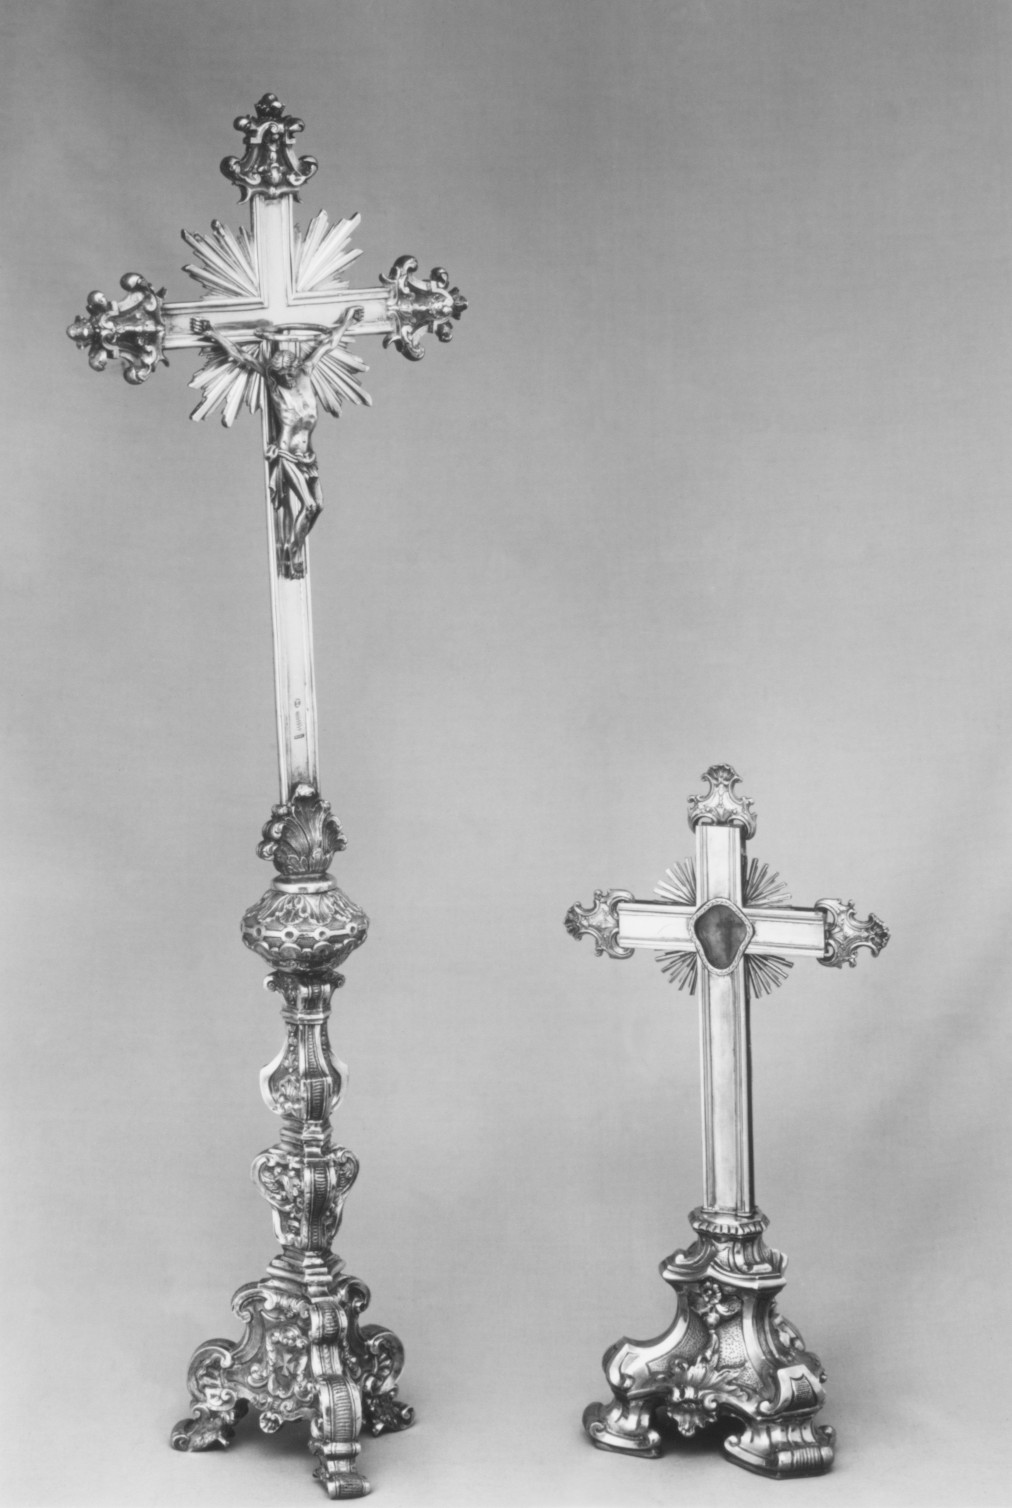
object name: altar cross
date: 1701-1800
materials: silver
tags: cross,jesus,crucifixion